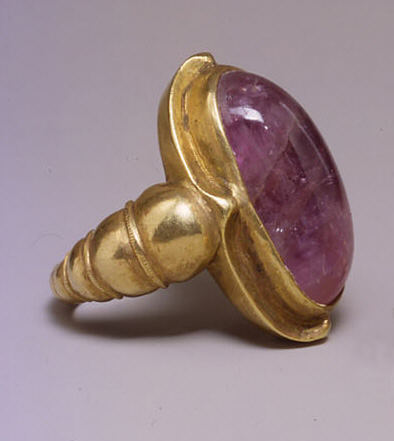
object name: ring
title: Ring with Large Purple Oval-Shaped Stone in Plain Mount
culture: indonesian, javanese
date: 701-933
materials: gold, stone